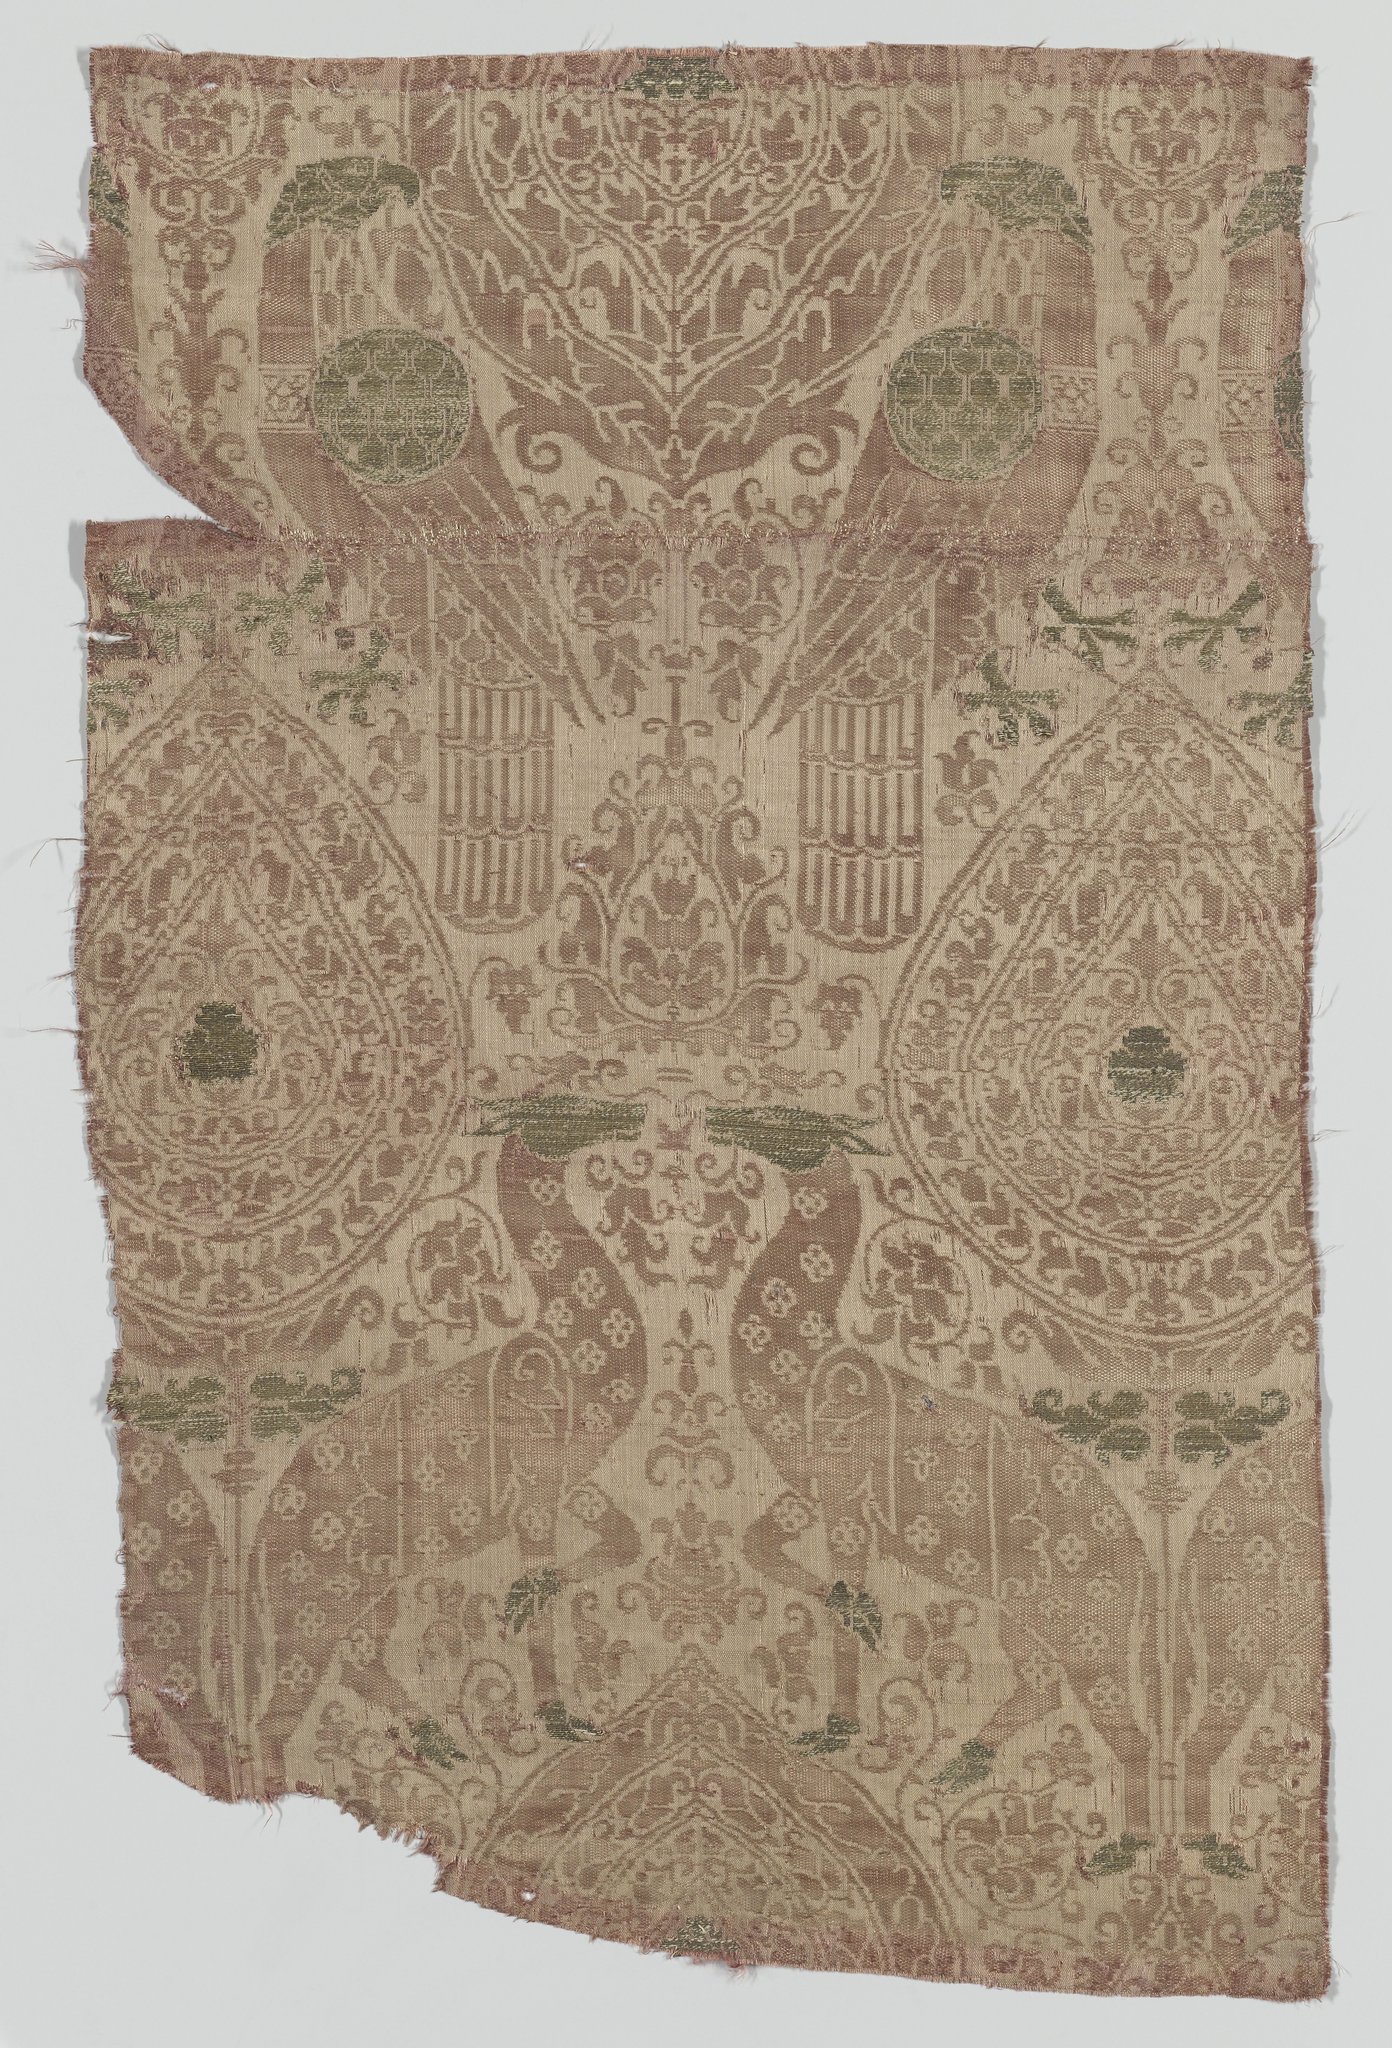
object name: fragment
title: Zijdeweefsel met een patroon van viervoeters, vogels, palmetten en arabesken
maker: Anonymous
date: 1300-1399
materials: silk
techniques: brocade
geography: lucca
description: Fragment van donkerrode zijde met een gestileerd patroon van twee gespiegelde viervoetige dieren en twee met de koppen naar elkaar toegewende vogels, waartussen palmetversiering en arabesken.